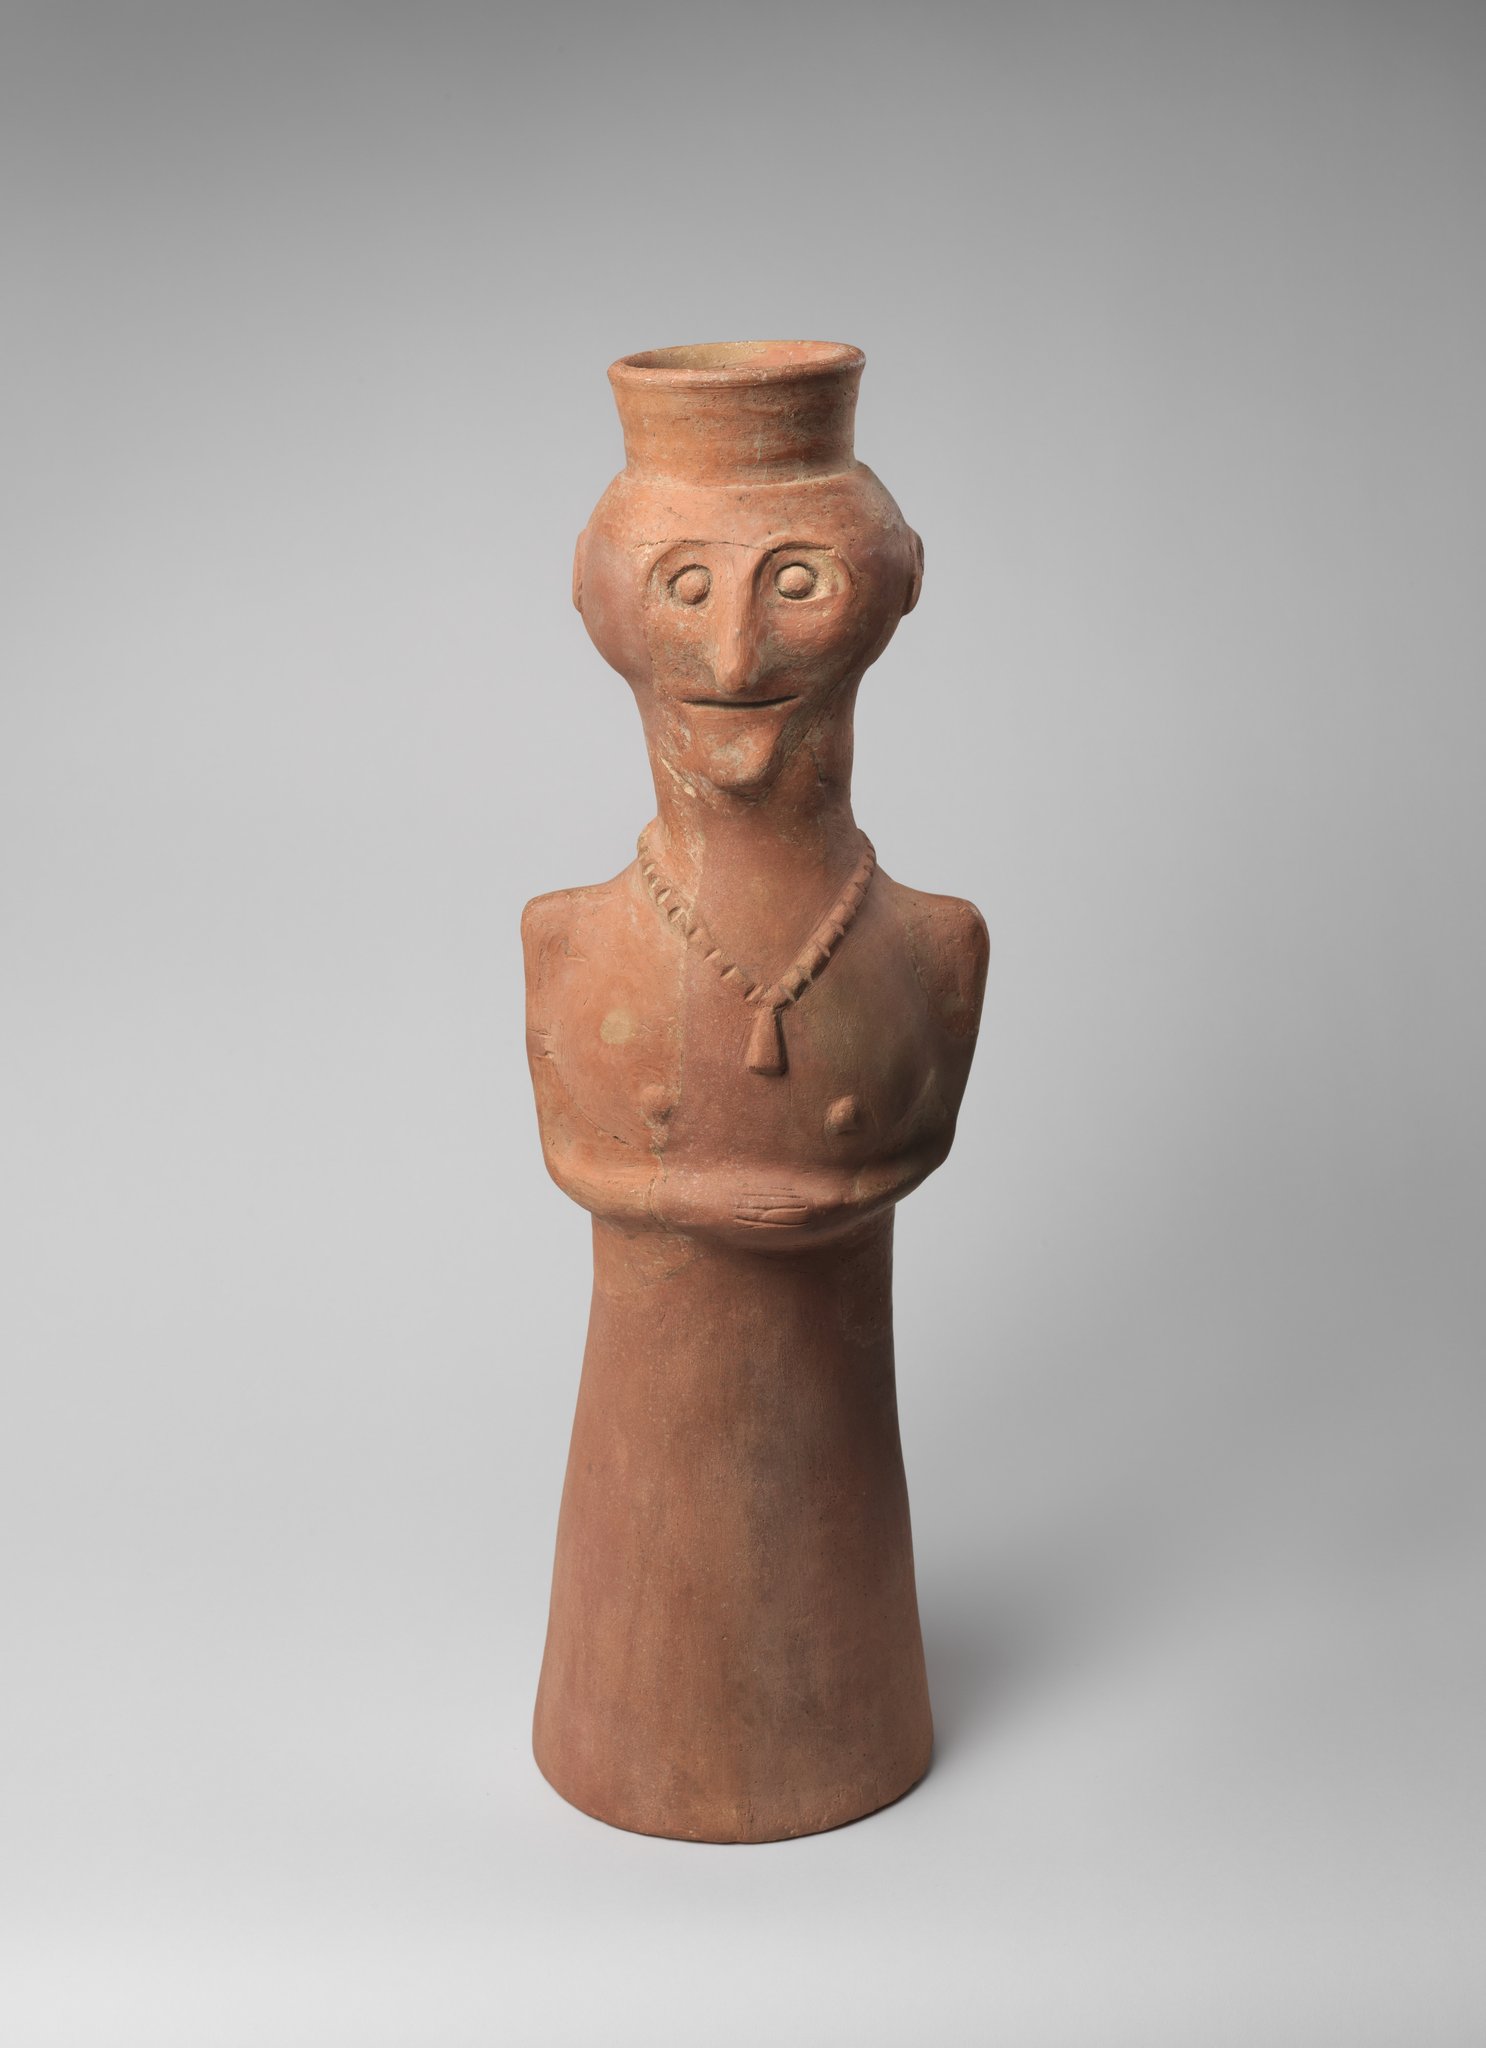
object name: vessel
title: Vessel in form of female (?) figure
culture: iranian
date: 700-501 BCE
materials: ceramic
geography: iran, luristan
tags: women